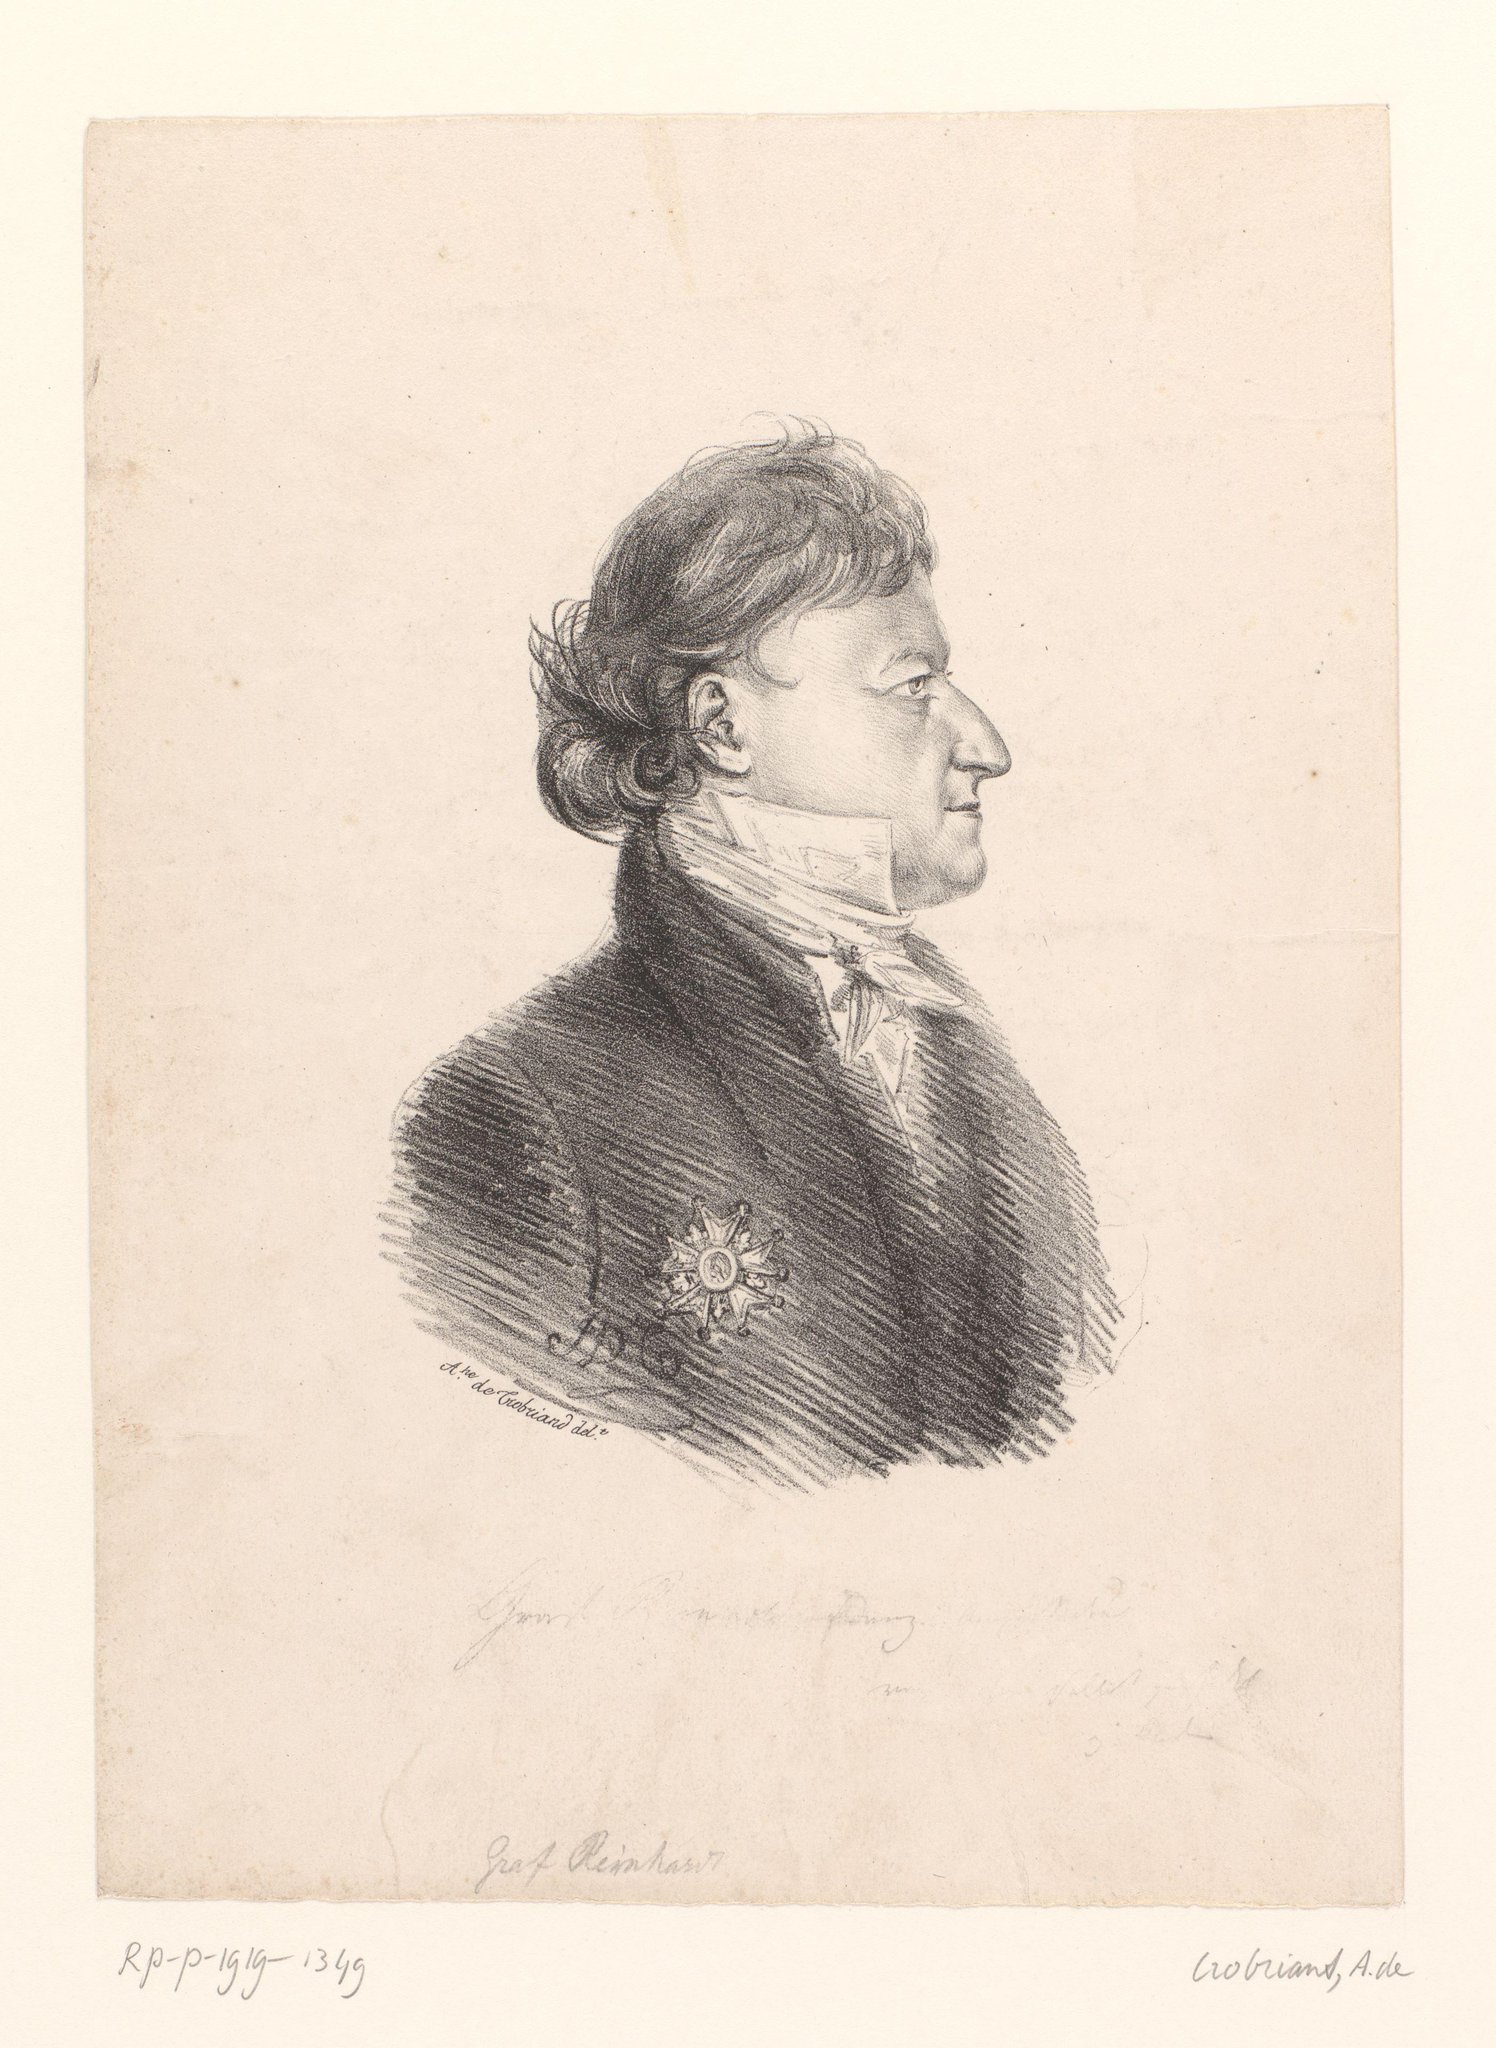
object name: print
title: Portret van graaf Charles-Frédéric Reinhard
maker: a. de crobriand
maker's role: print maker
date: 1799-1837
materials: paper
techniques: lithograph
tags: paris, politician, historical persons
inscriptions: collector's mark: Lugt 2228a